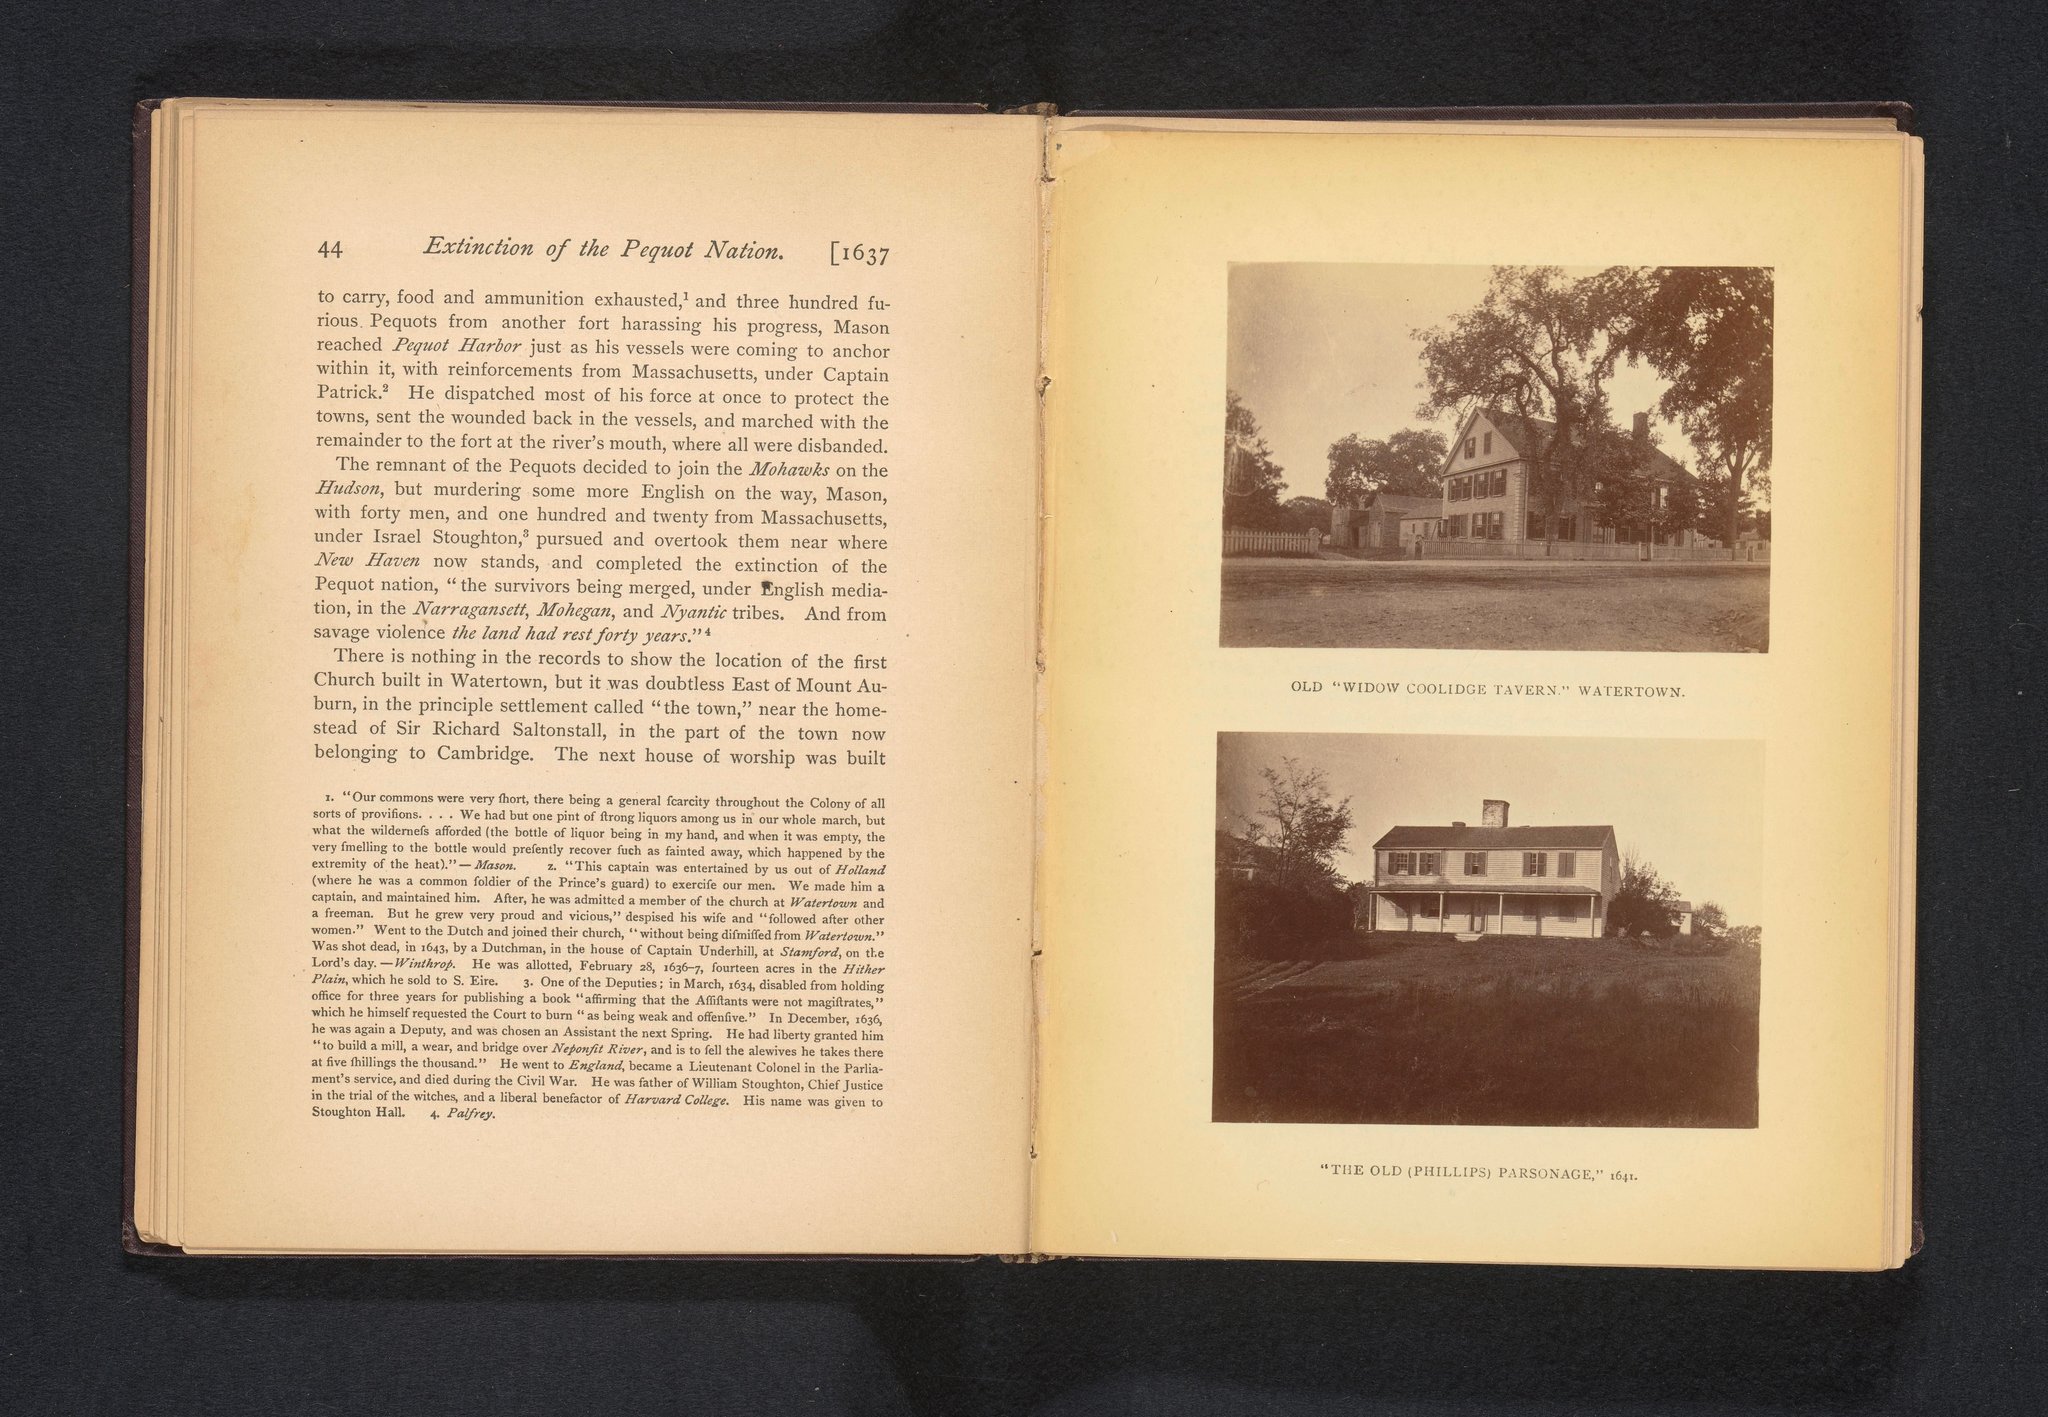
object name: page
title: Gezicht op een herberg in Watertown, Massachusetts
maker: thomas r. lewis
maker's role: publisher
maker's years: 1845-1901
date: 1874-1879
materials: photographic support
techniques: albumen print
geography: watertown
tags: hotel, hostelry, inn